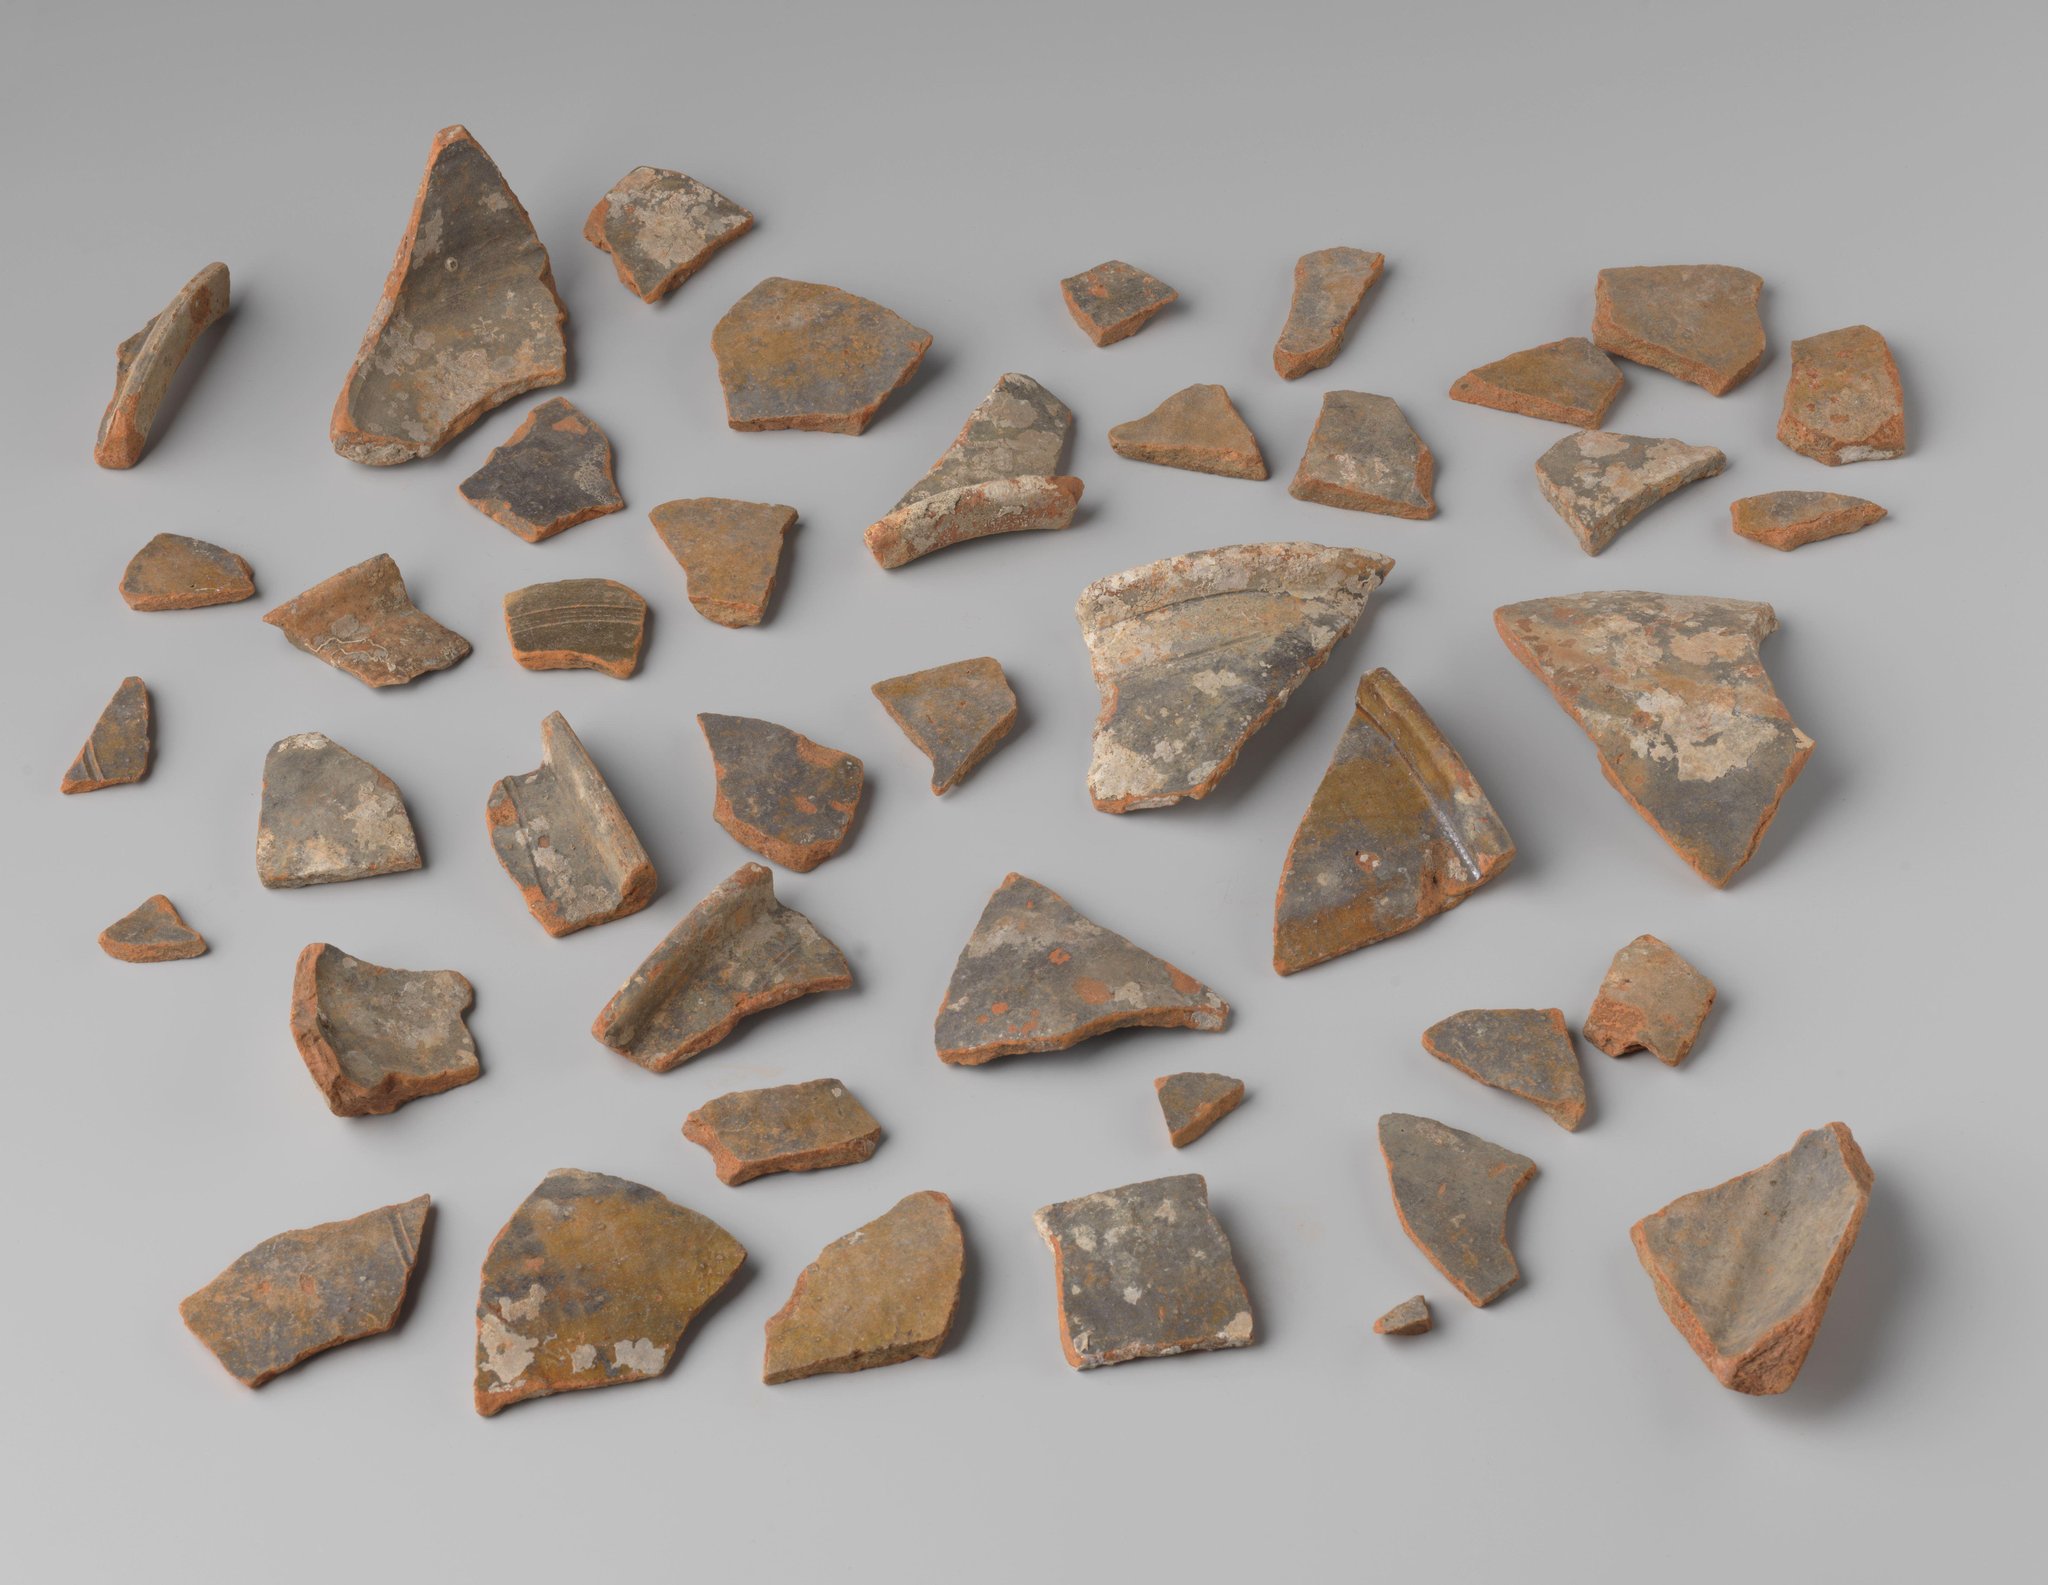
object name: sherd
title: Scherven aardewerk uit V.O.C.-schip de 'Witte Leeuw'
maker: Anonymous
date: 1613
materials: earthenware, glaze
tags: verenigde oostindische compagnie, sint-helena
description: Scherven geglazuurd roodbakkend aardewerk uit V.O.C.-schip de 'Witte Leeuw'.